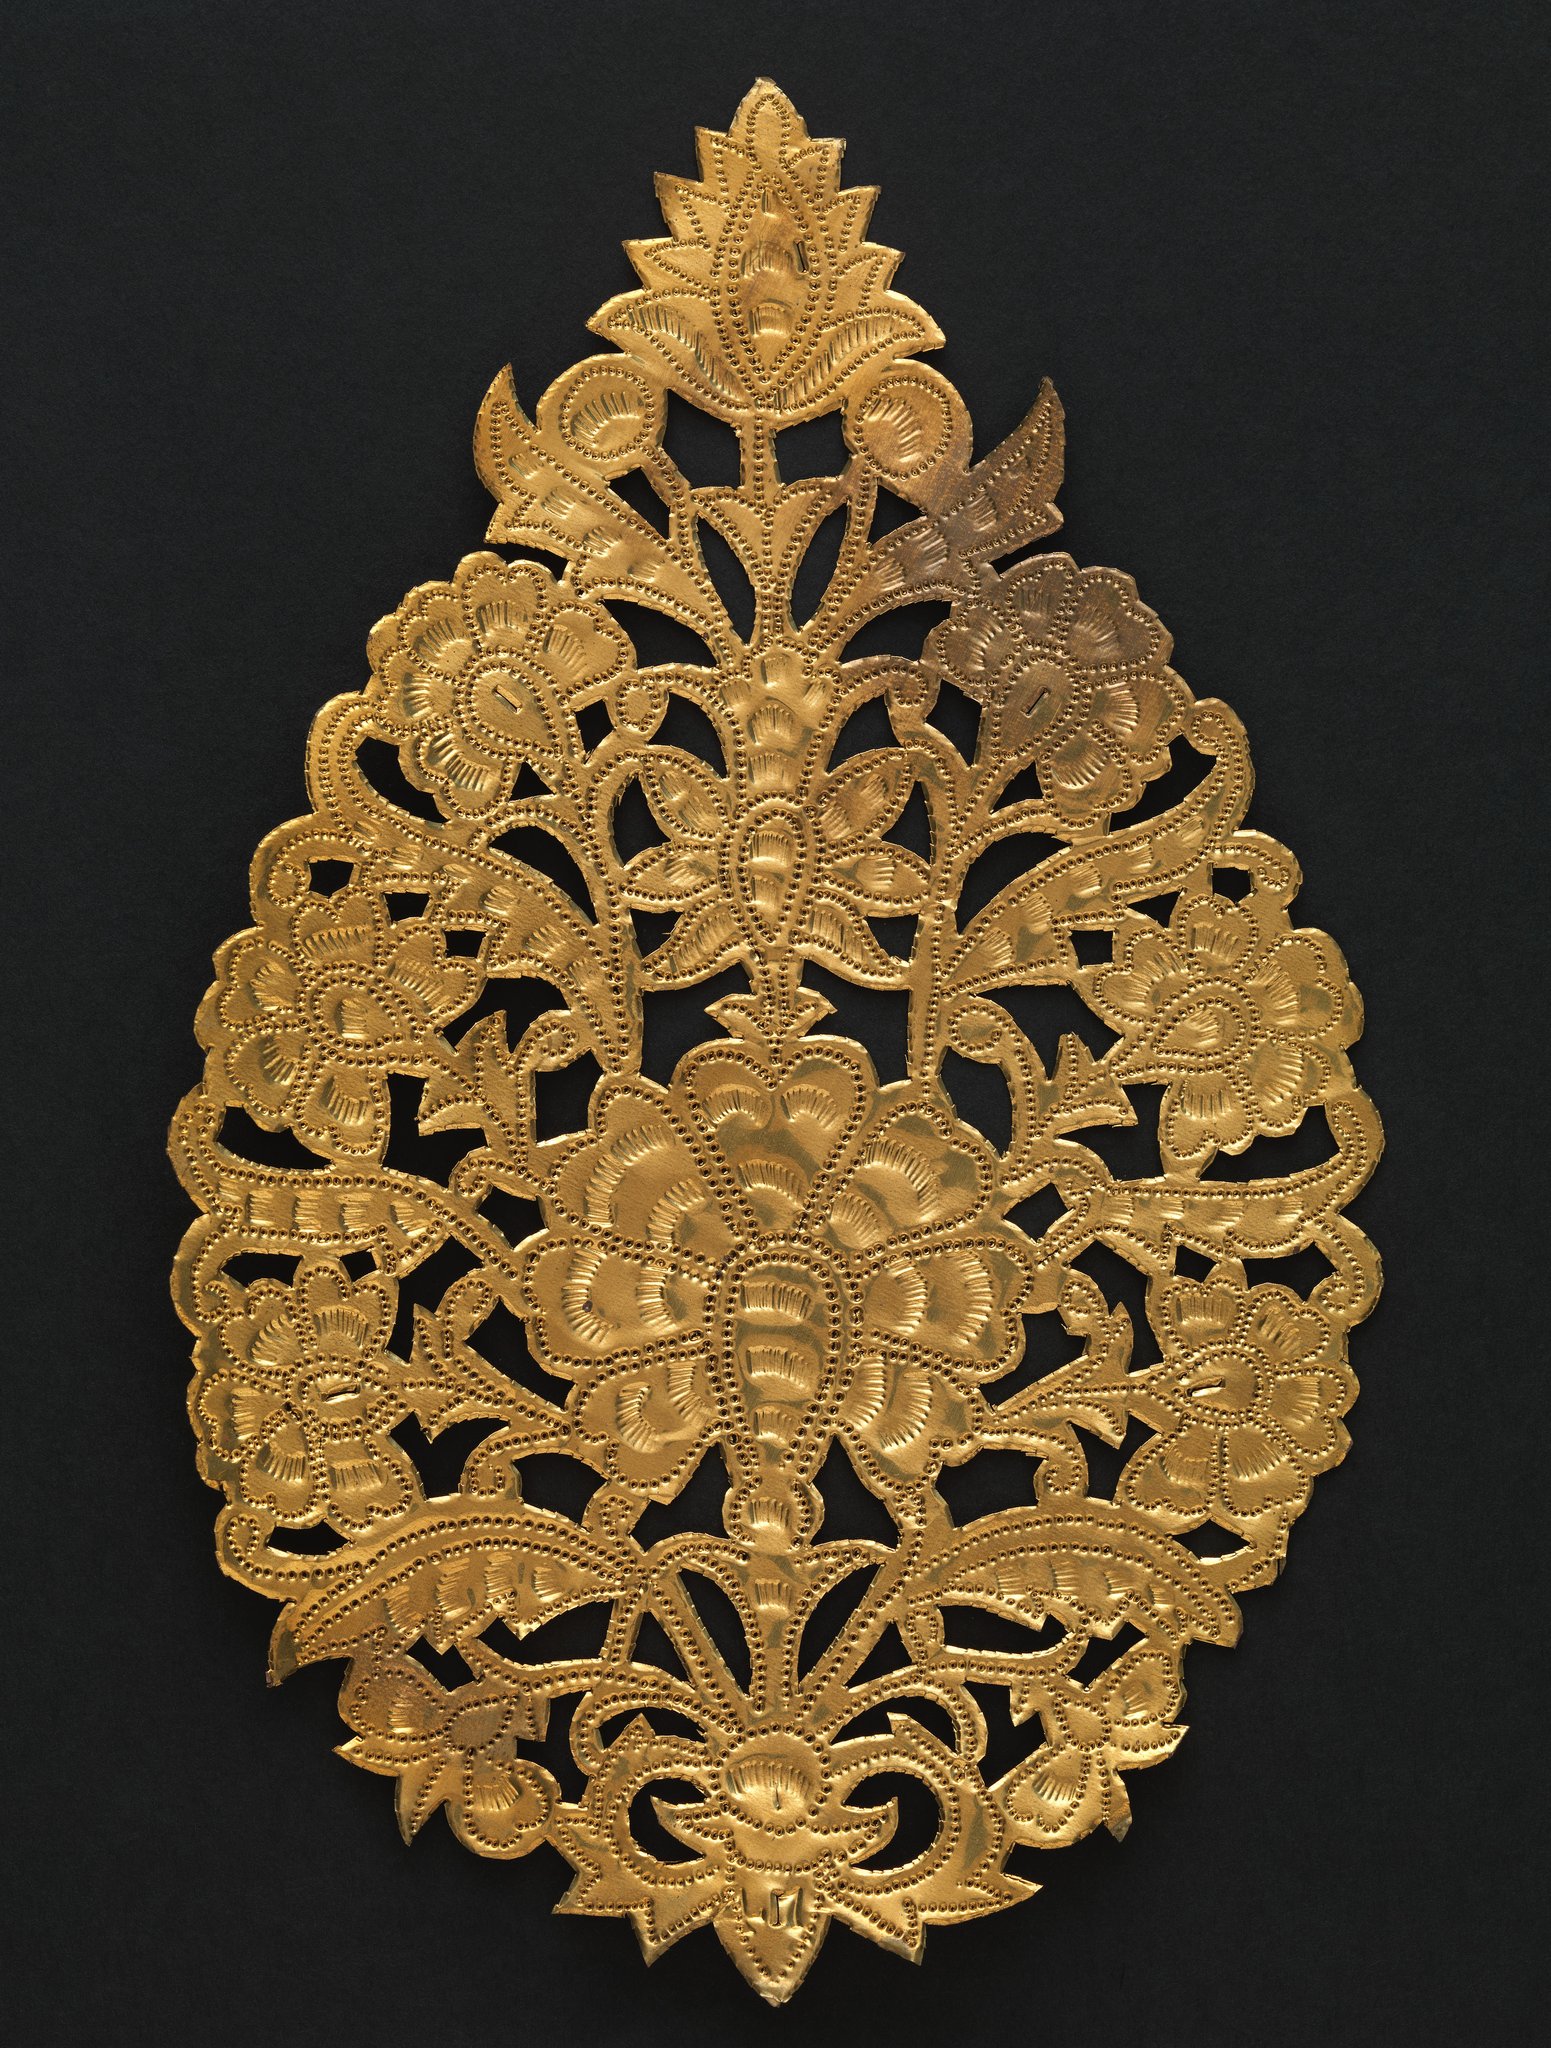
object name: cutout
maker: lockwood de forest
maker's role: designer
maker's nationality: american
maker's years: 1850-1932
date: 1892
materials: brass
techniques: chasing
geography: india